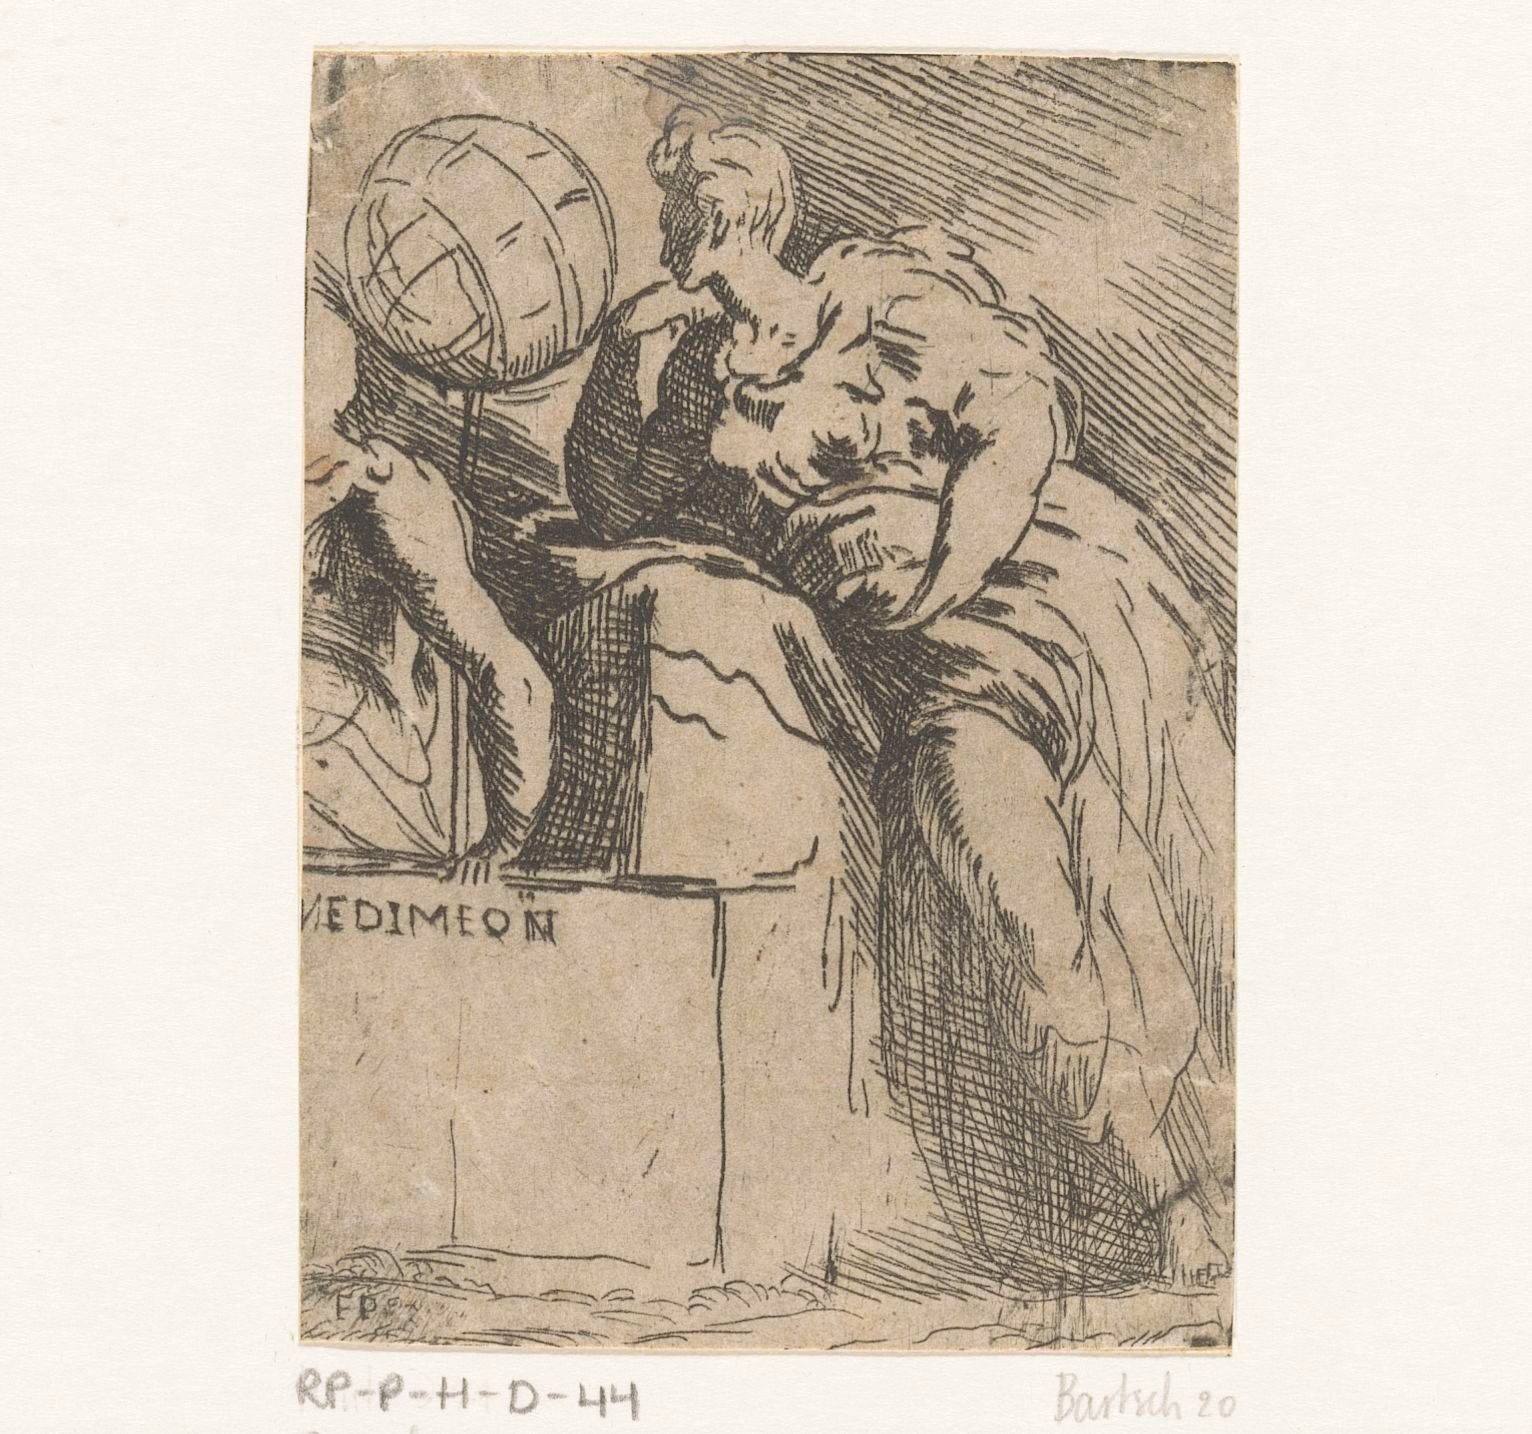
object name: print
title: Vrouw een armillairsfeer bestuderend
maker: monogrammist fp (italië; 16e eeuw)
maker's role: print maker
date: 1500-1599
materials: paper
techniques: etching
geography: italy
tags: armillary sphere, skeleton celestial globe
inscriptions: collector's mark: Lugt 10, collector's mark: ‘Hinloopen’